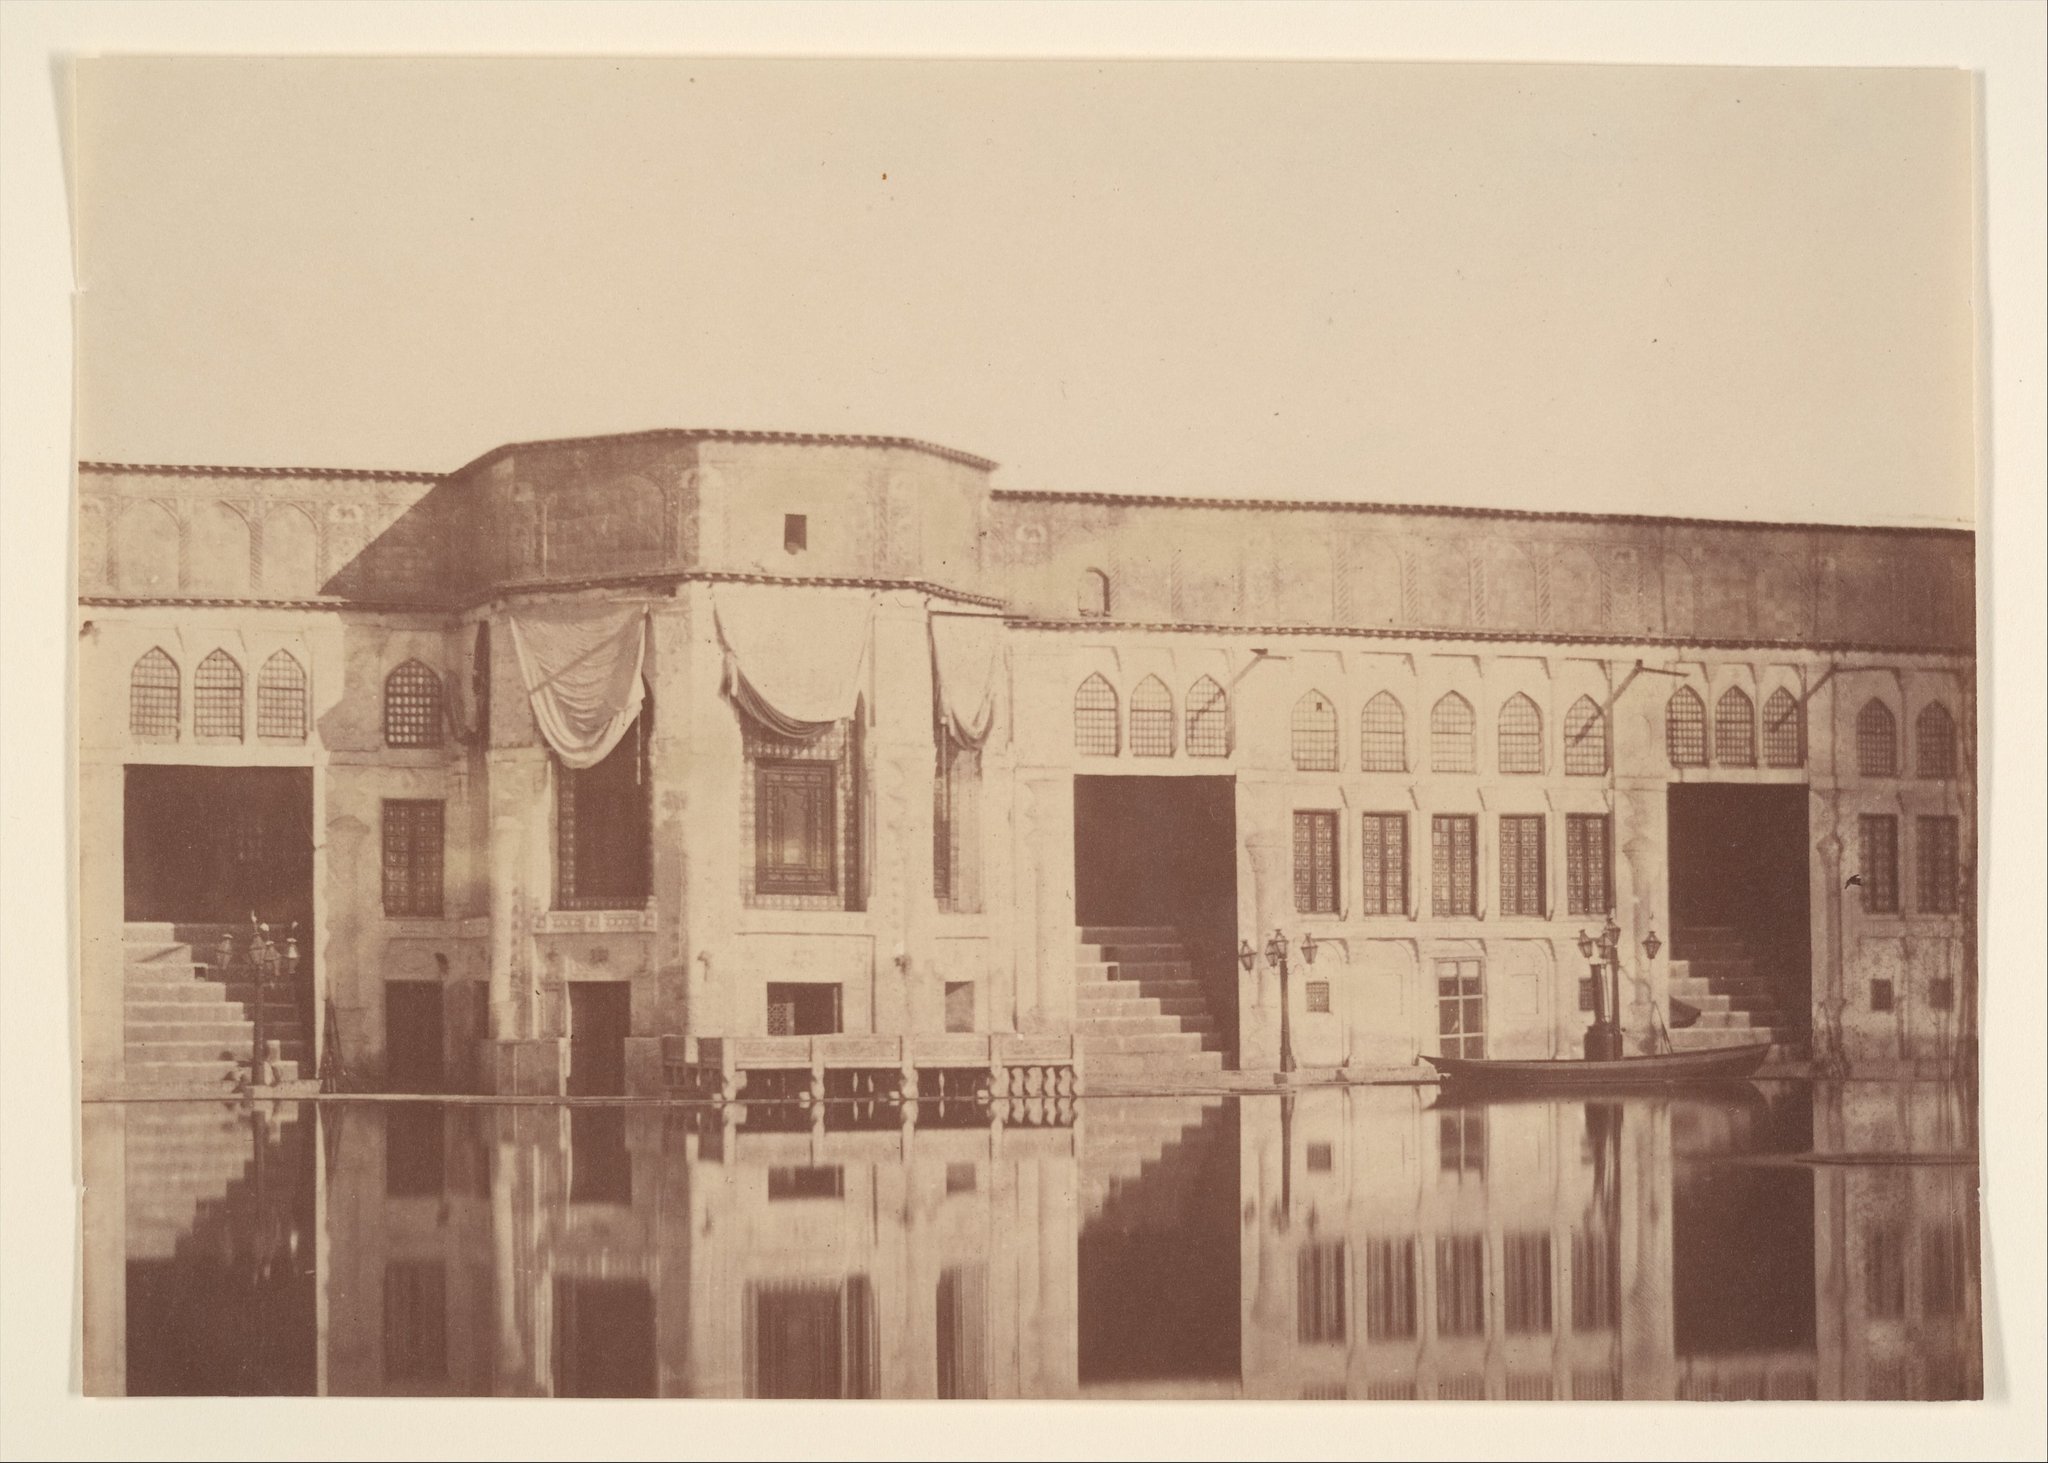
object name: photograph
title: [Summer residence (Qasr) of the Shah, Emarat-e xoruji, Teheran, Iran]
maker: luigi pesce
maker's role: artist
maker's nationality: italian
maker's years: 1818-1891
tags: architecture,buildings